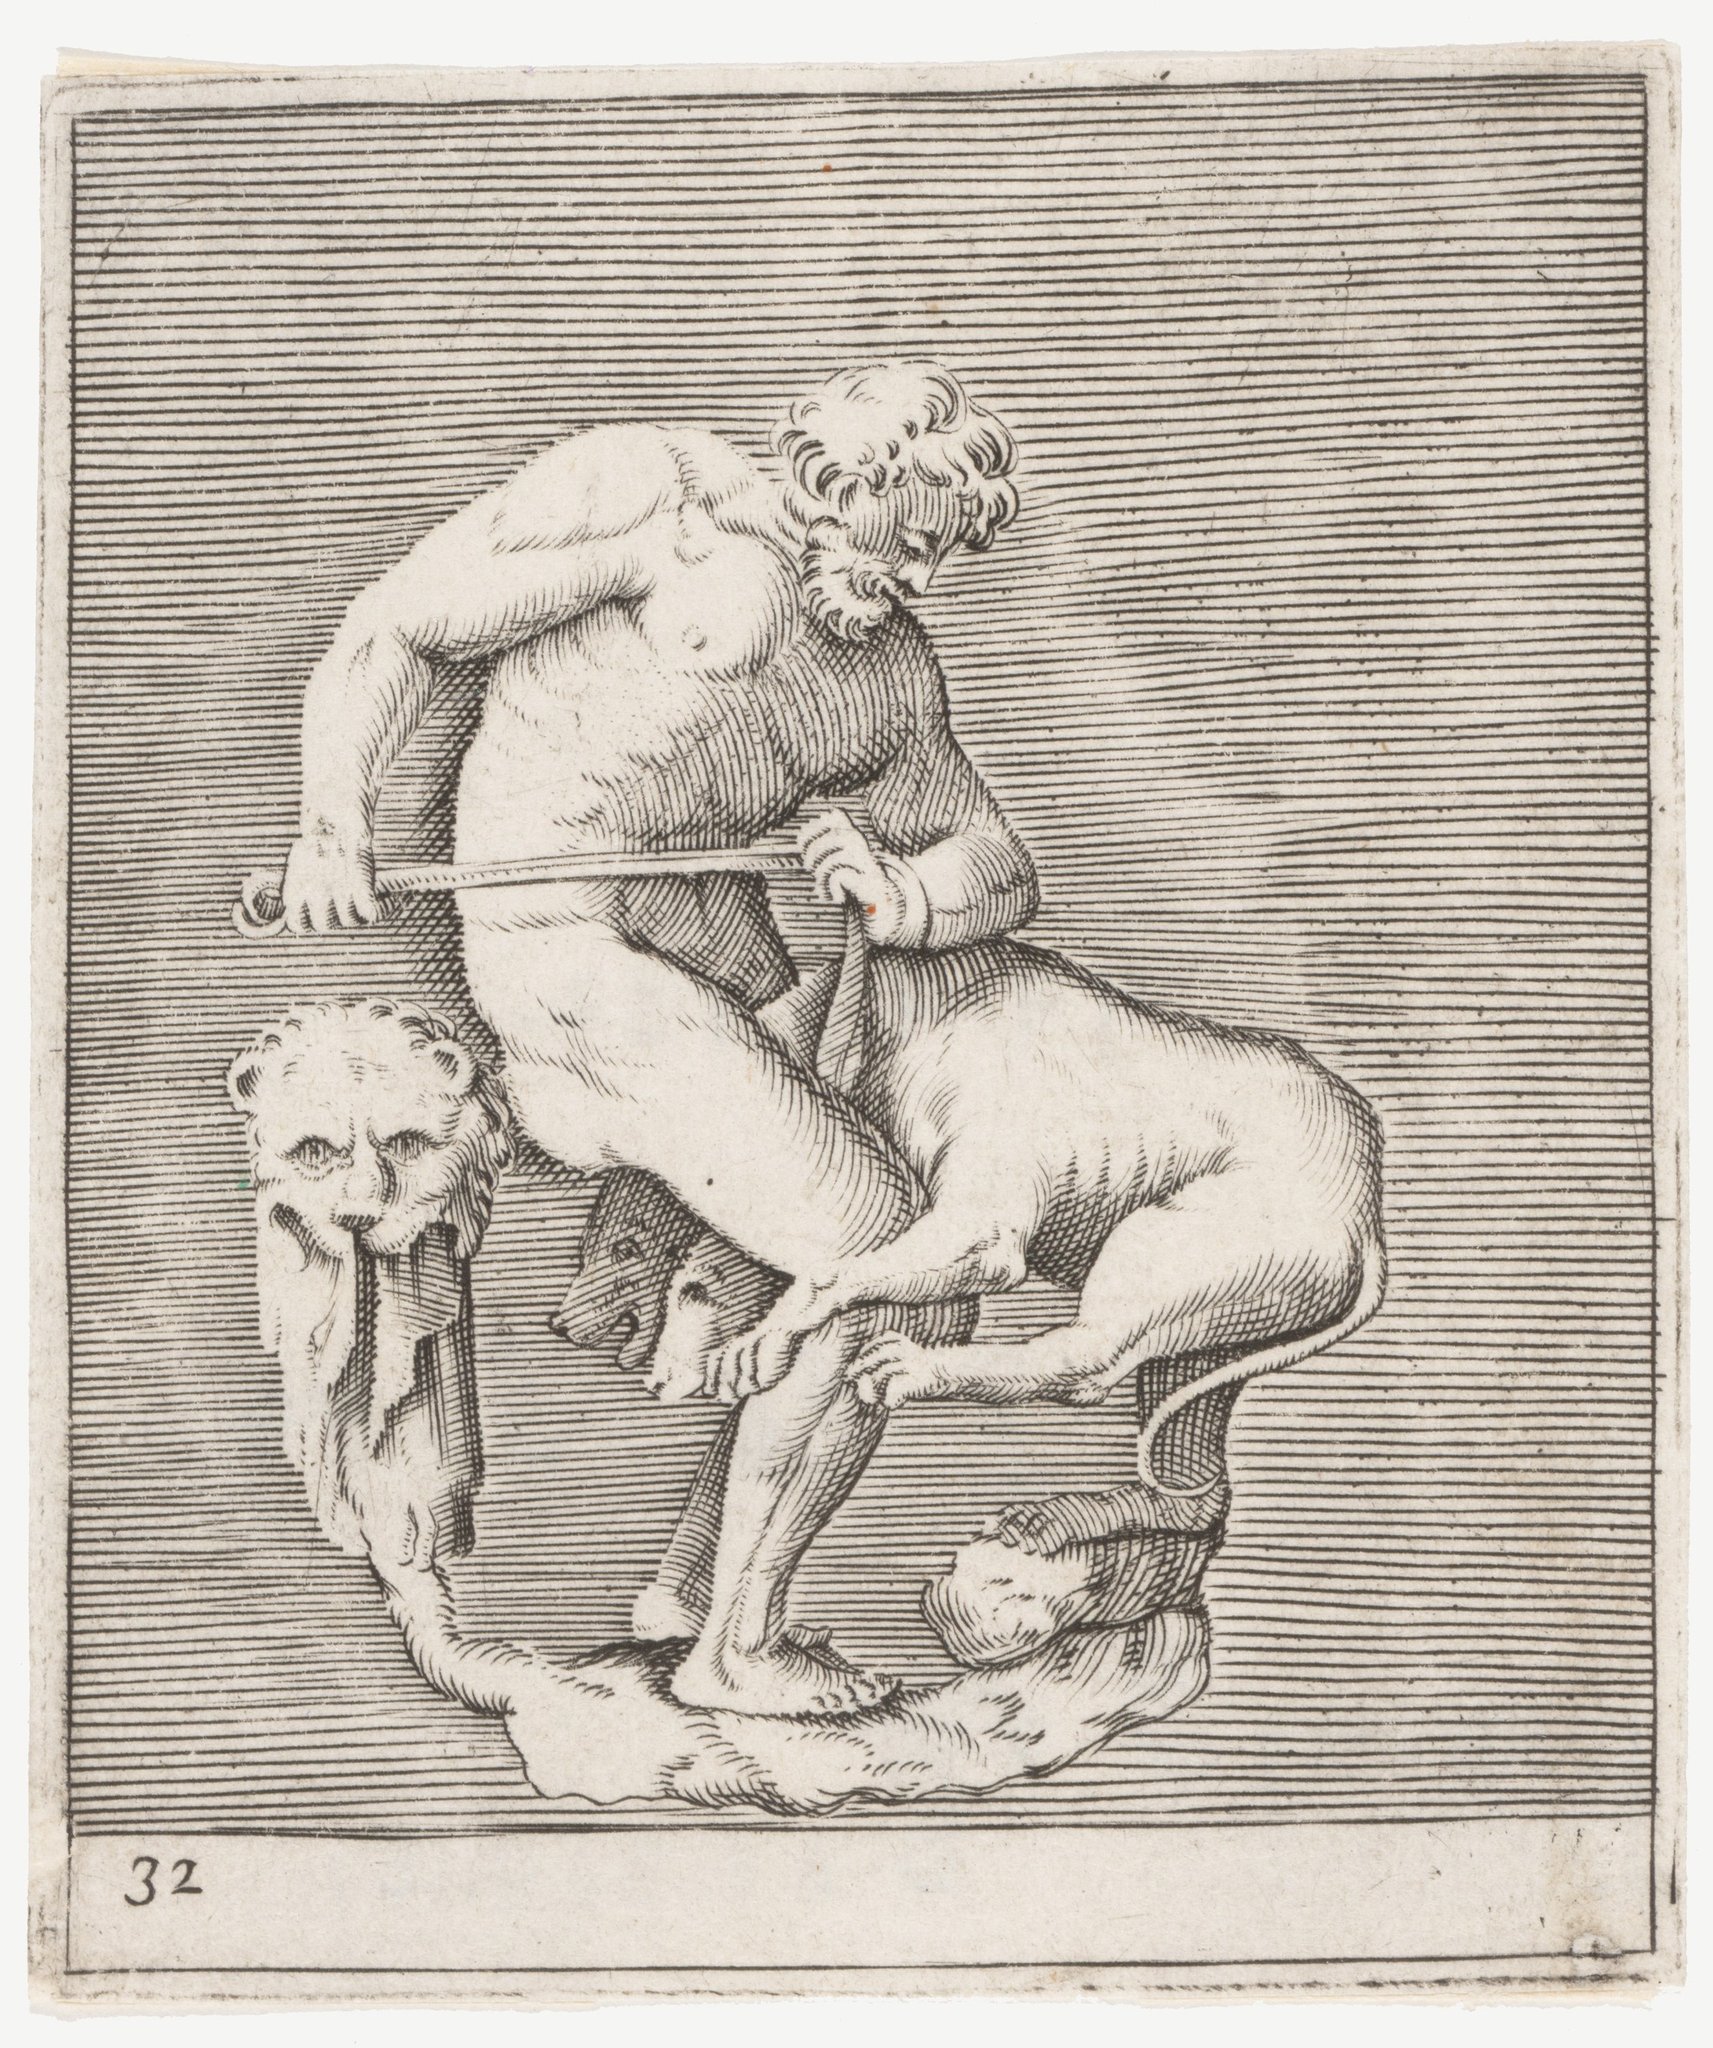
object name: print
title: Hercules and Cerberus, from "Ex Antiquis Cameorum et Gemmae Delineata"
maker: anonymous, italian, 16th century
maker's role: artist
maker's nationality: italian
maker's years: 1500-1600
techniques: engraving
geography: rome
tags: hercules